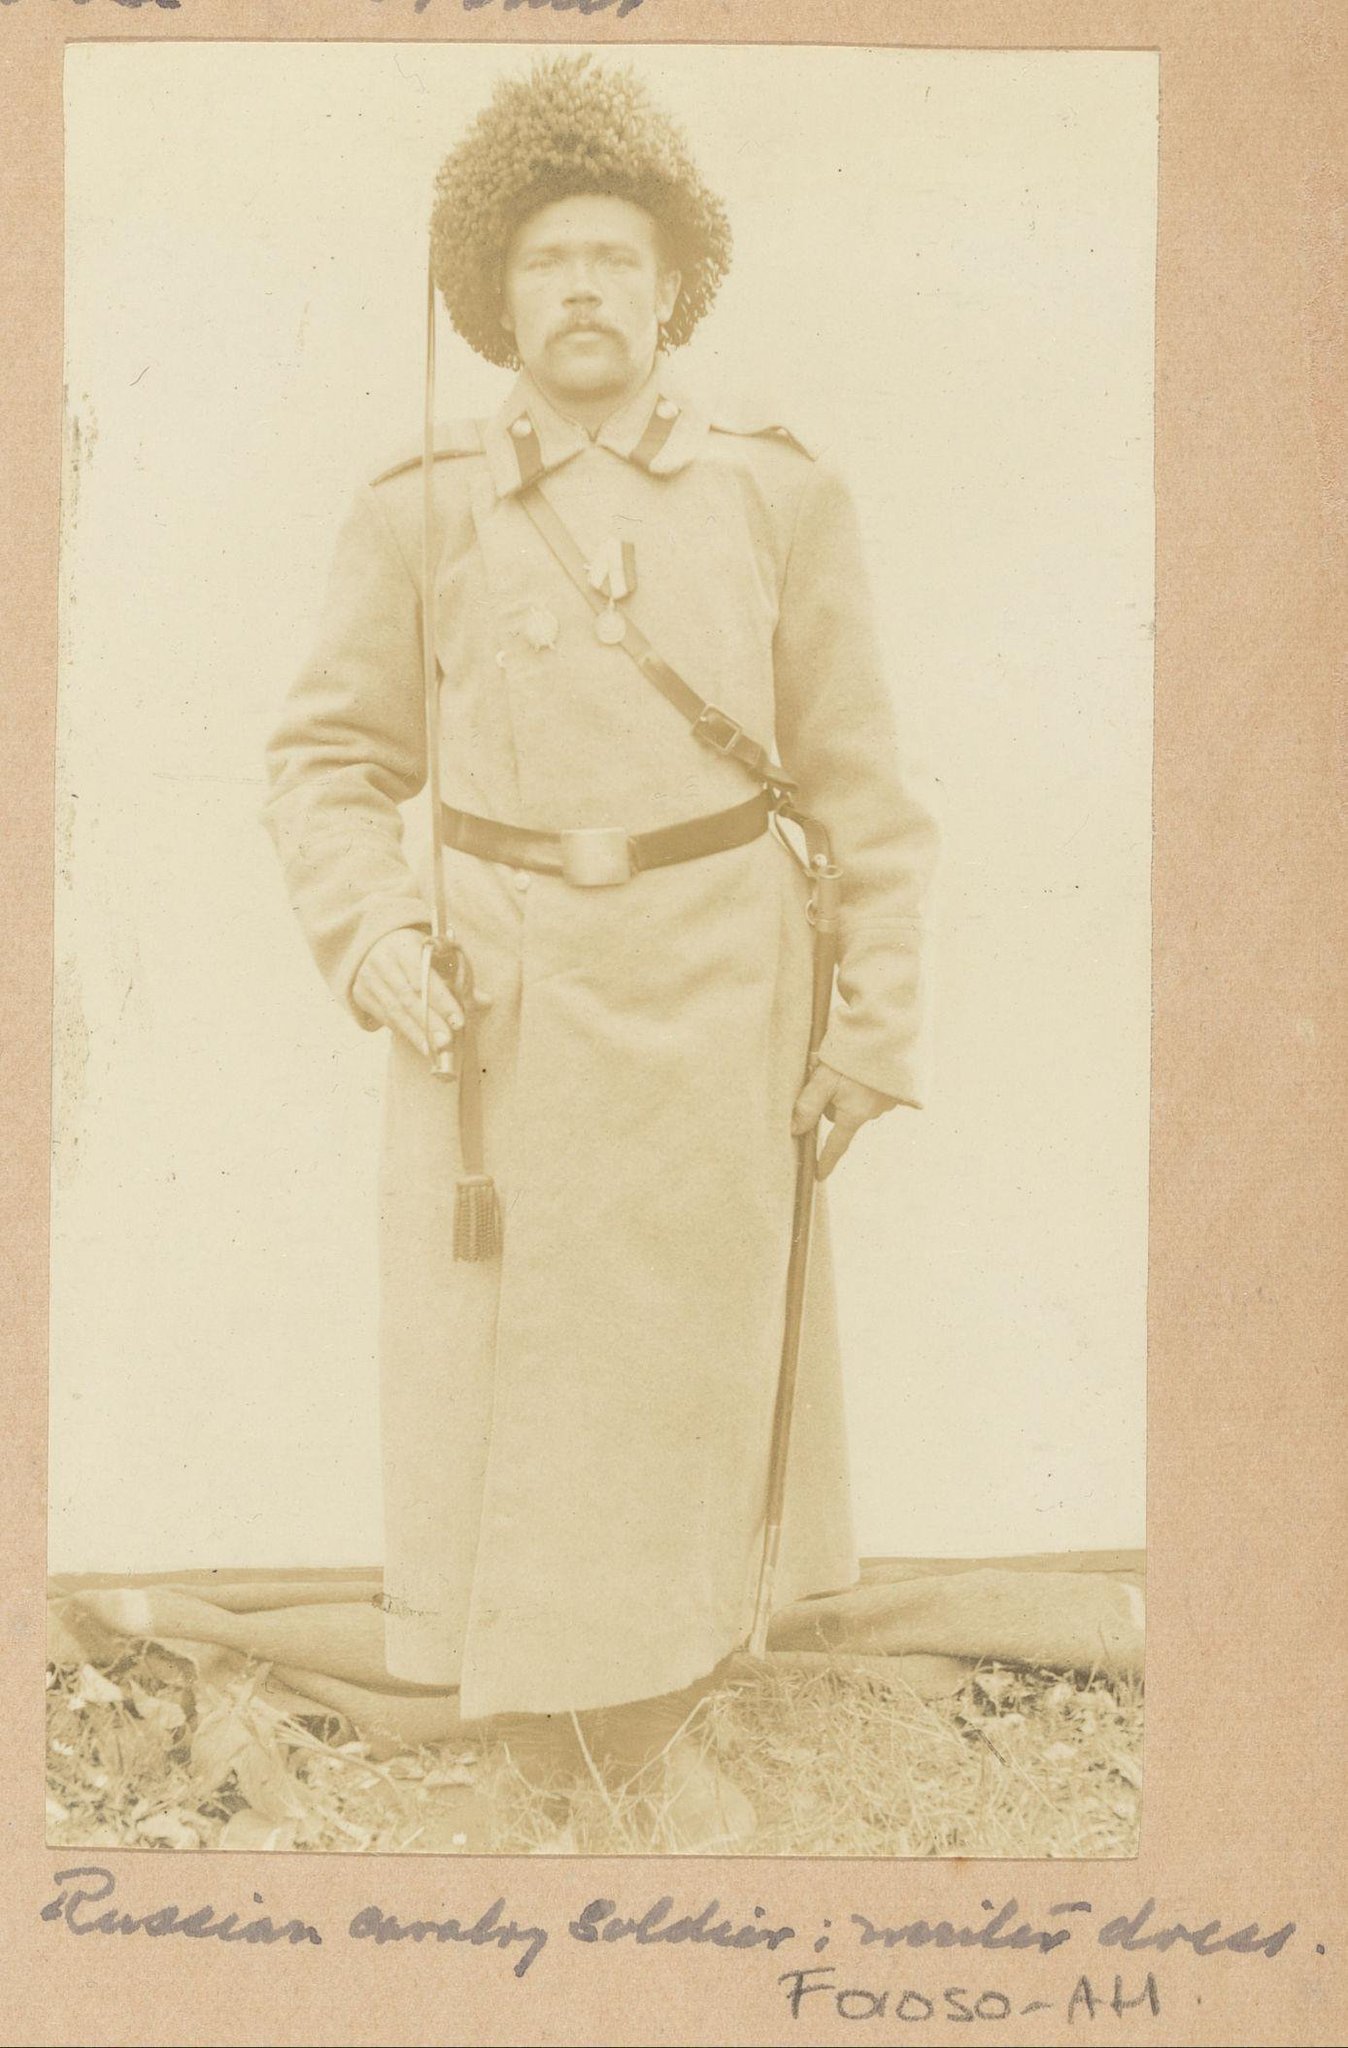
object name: photograph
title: Portret van een Russische cavaleriesoldaat in wintertenue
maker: joseph cheetham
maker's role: engineer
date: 1903-1904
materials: photographic support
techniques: gelatin silver print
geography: russia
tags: land forces (+ cavalry, horsemen), hacking and thrusting weapons (with name), (military) uniforms, russia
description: Onderdeel van Fotoalbum van de Engelse familie Cheetham met opnames van hun verblijf in Rusland.